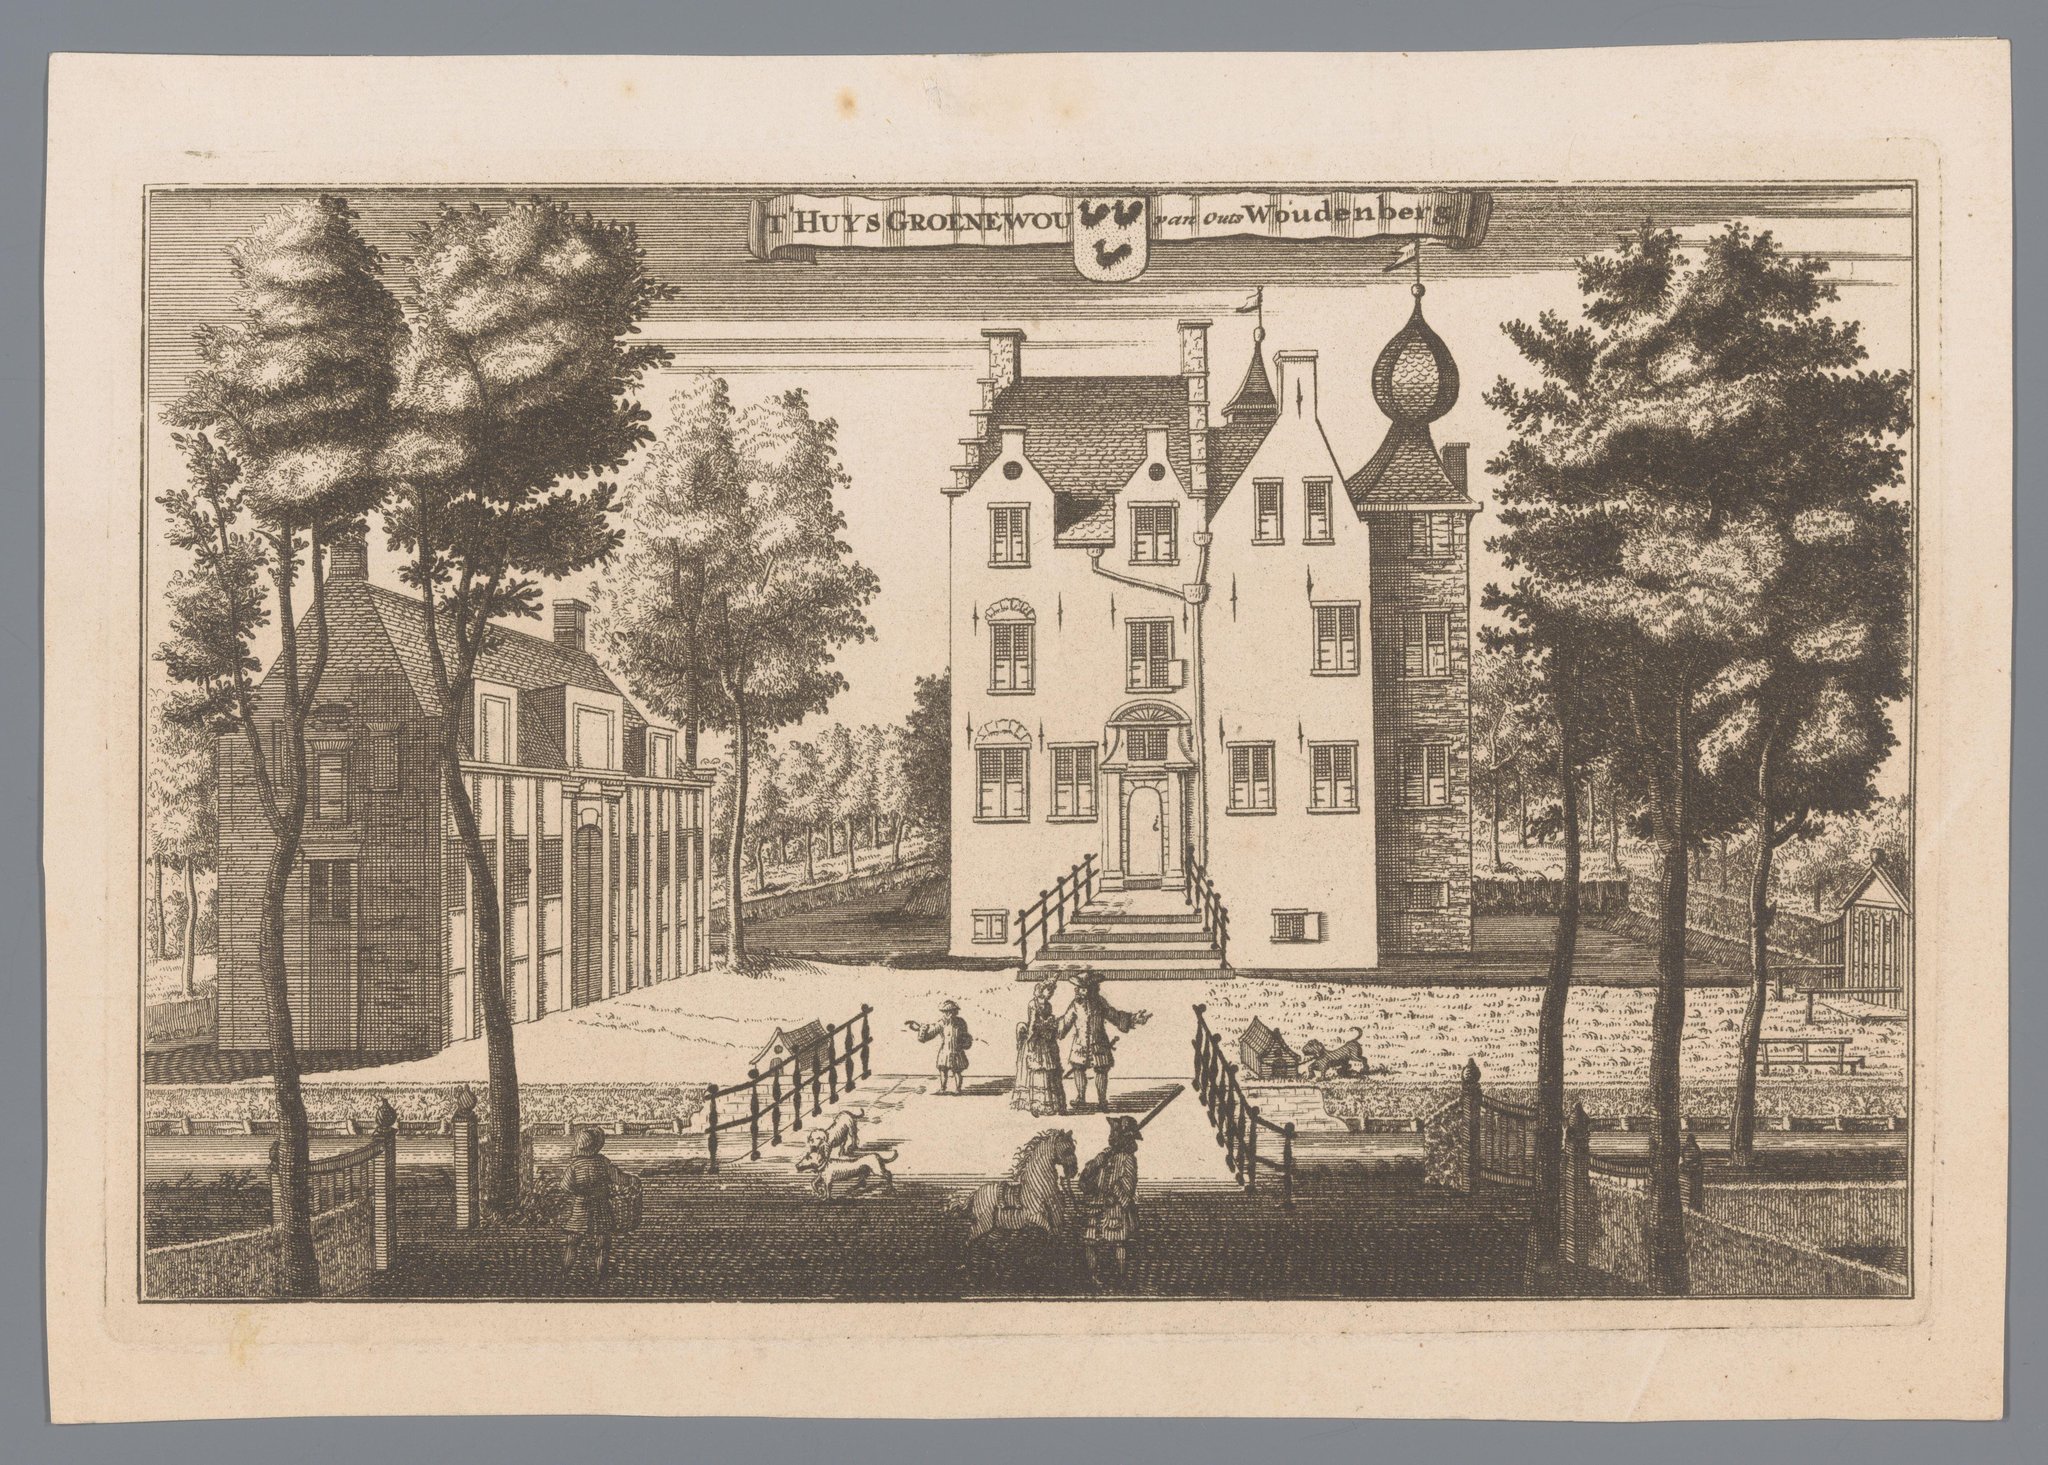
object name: print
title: t'Huys Groenewou van outs Woudenberg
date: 1698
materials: paper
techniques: engraving, etching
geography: utrecht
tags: castle, landscape with tower or castle, woudenberg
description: Prent uit: De Ridder-matige Huysen en Gesichten in de Provincie van Utrecht. Utrecht: Caspar Specht, 1698.